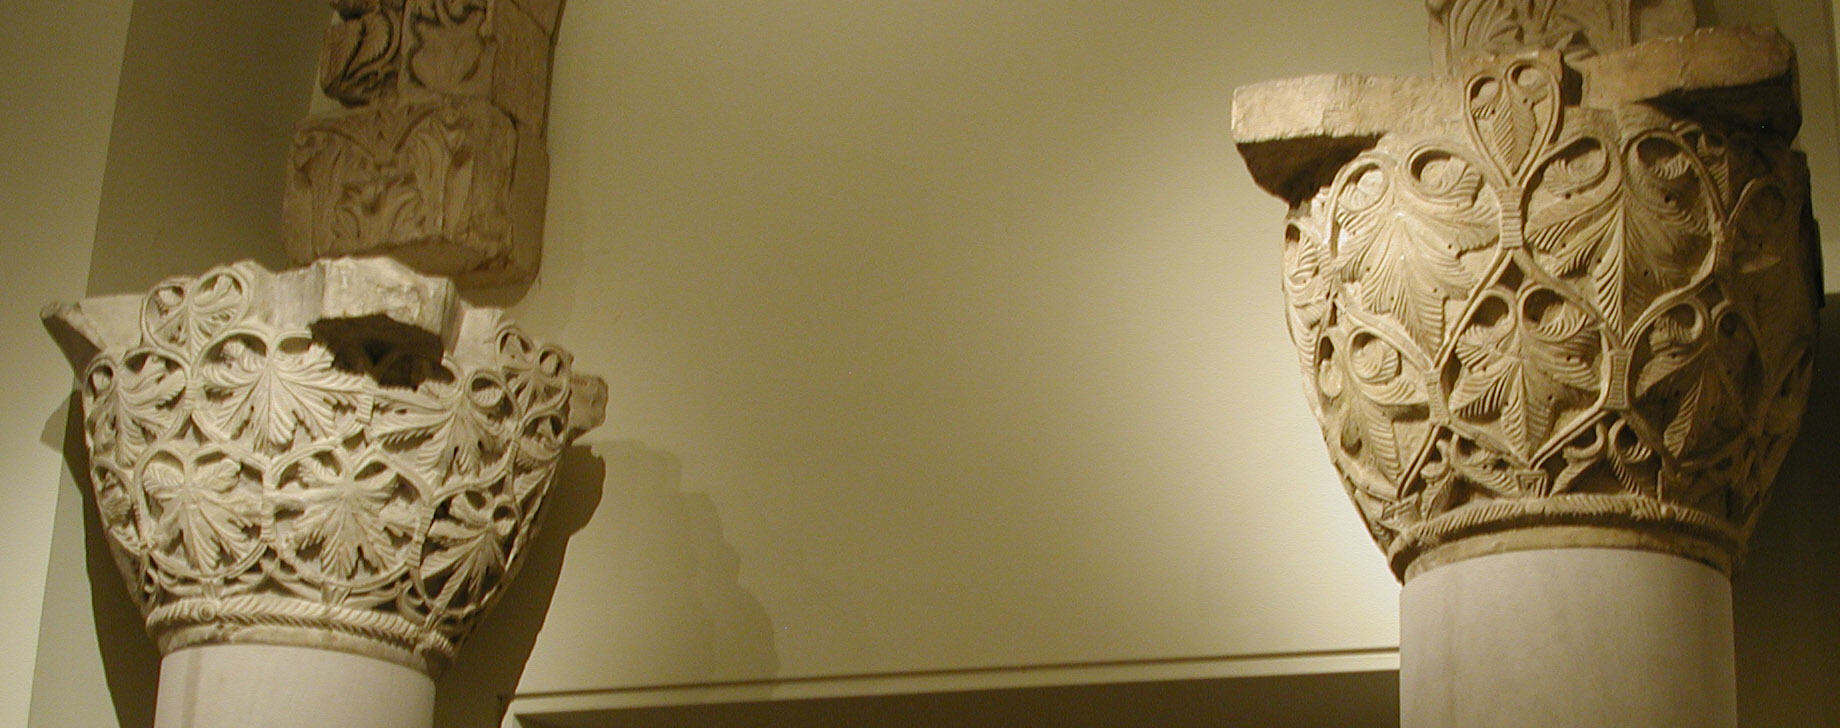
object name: capital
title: Capital with a Pattern of Grape Leaves and Vines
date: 501-700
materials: limestone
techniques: carving, relief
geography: egypt